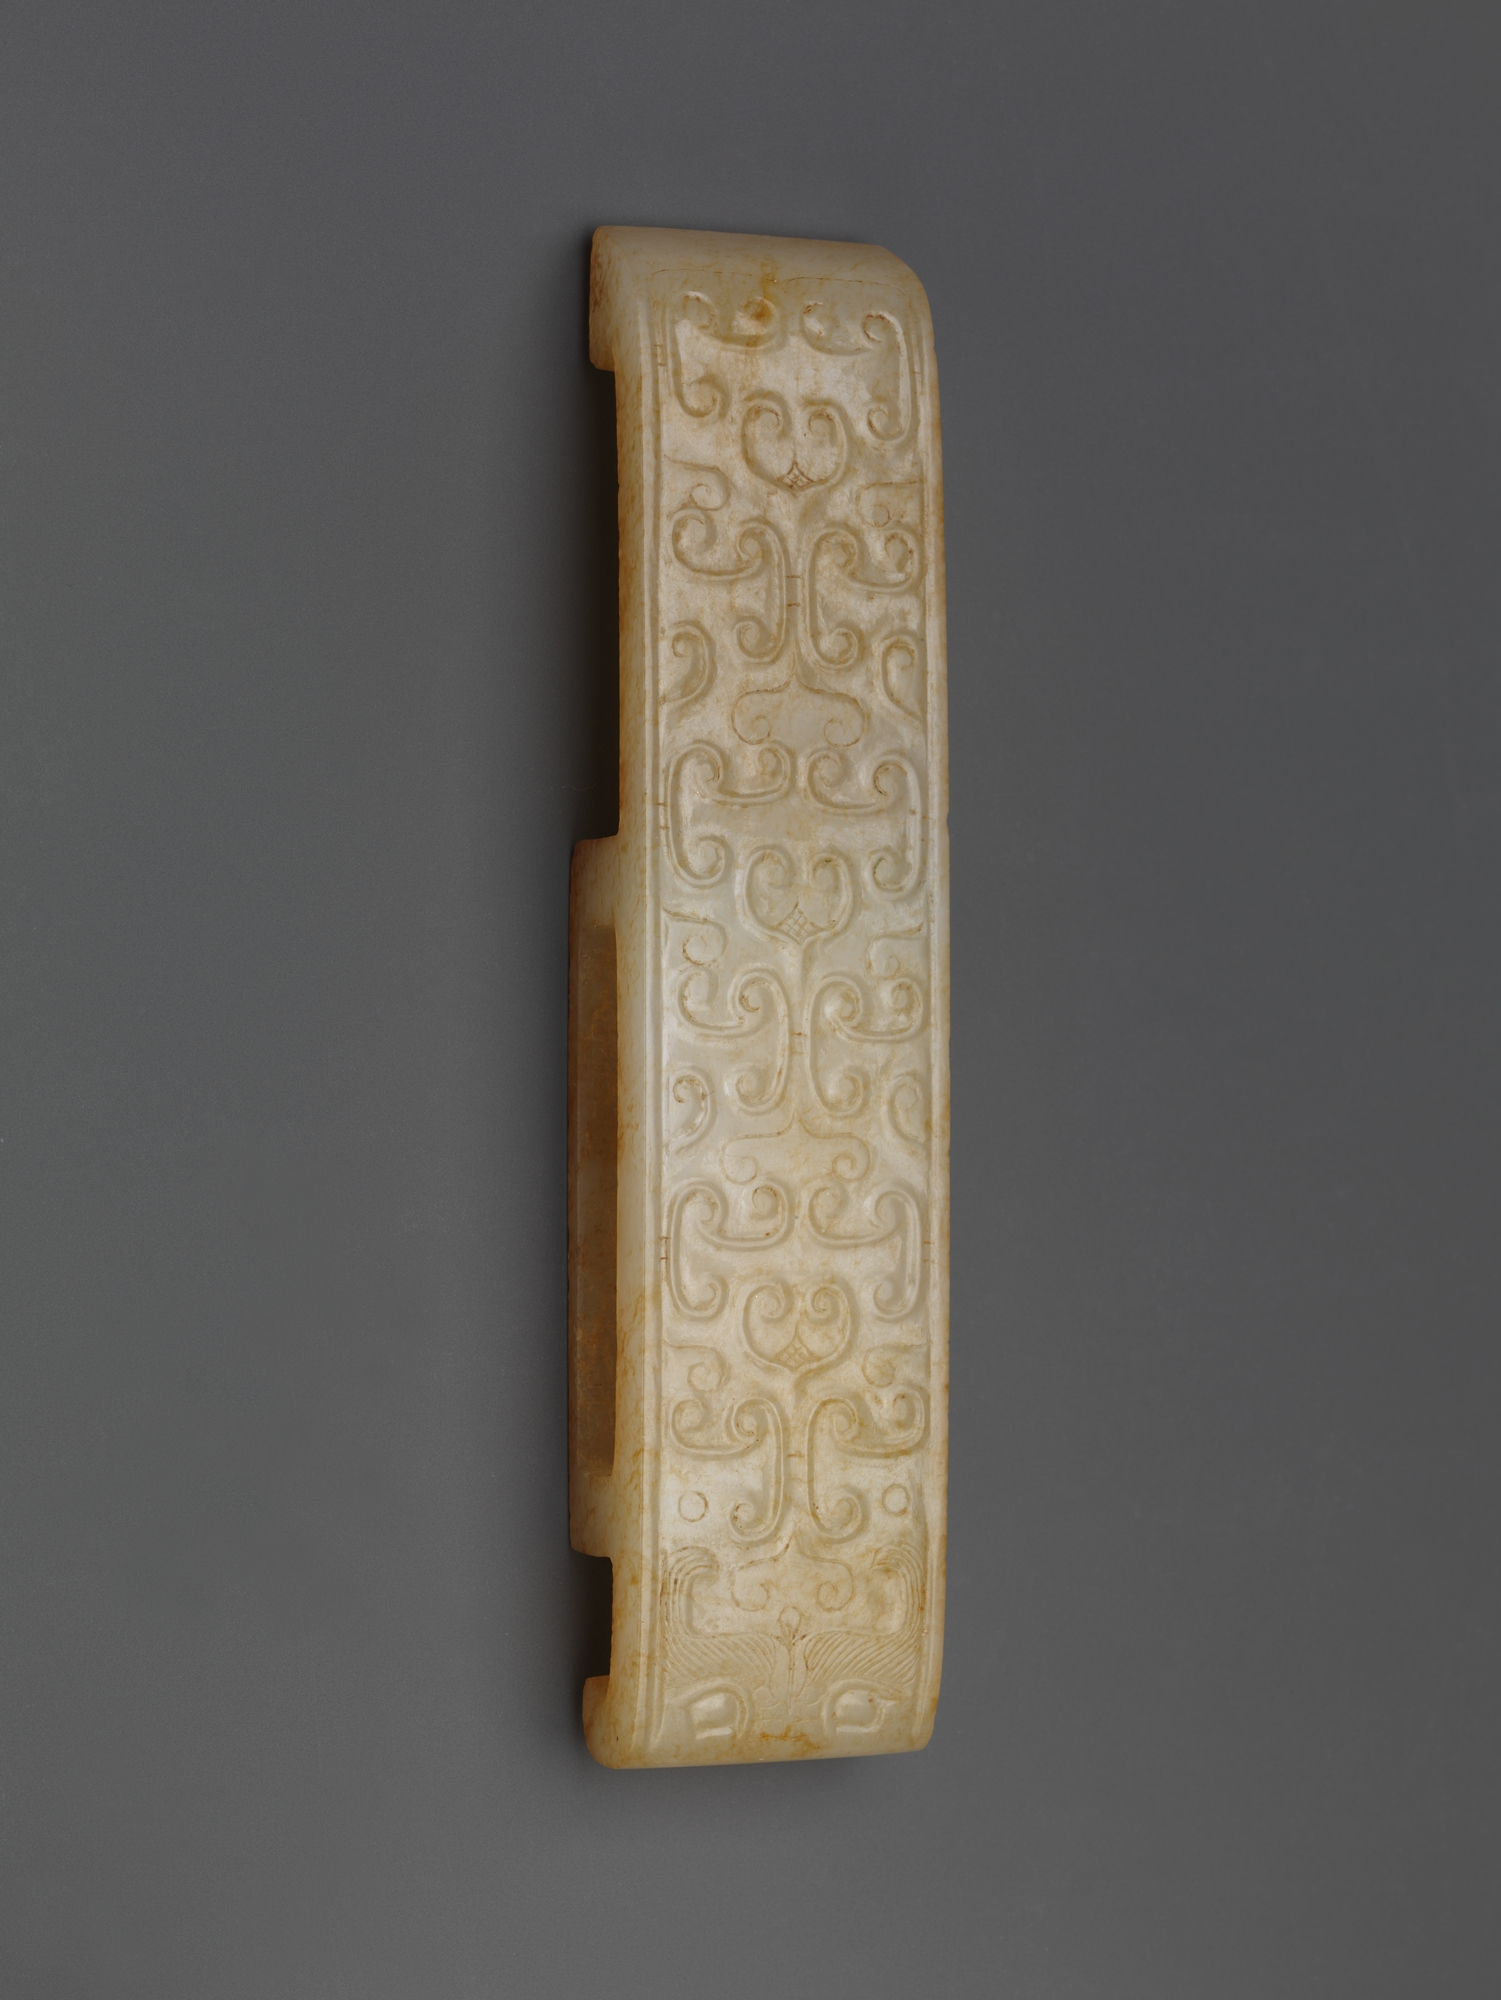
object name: scabbard slide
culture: chinese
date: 300-201 BCE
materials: jade